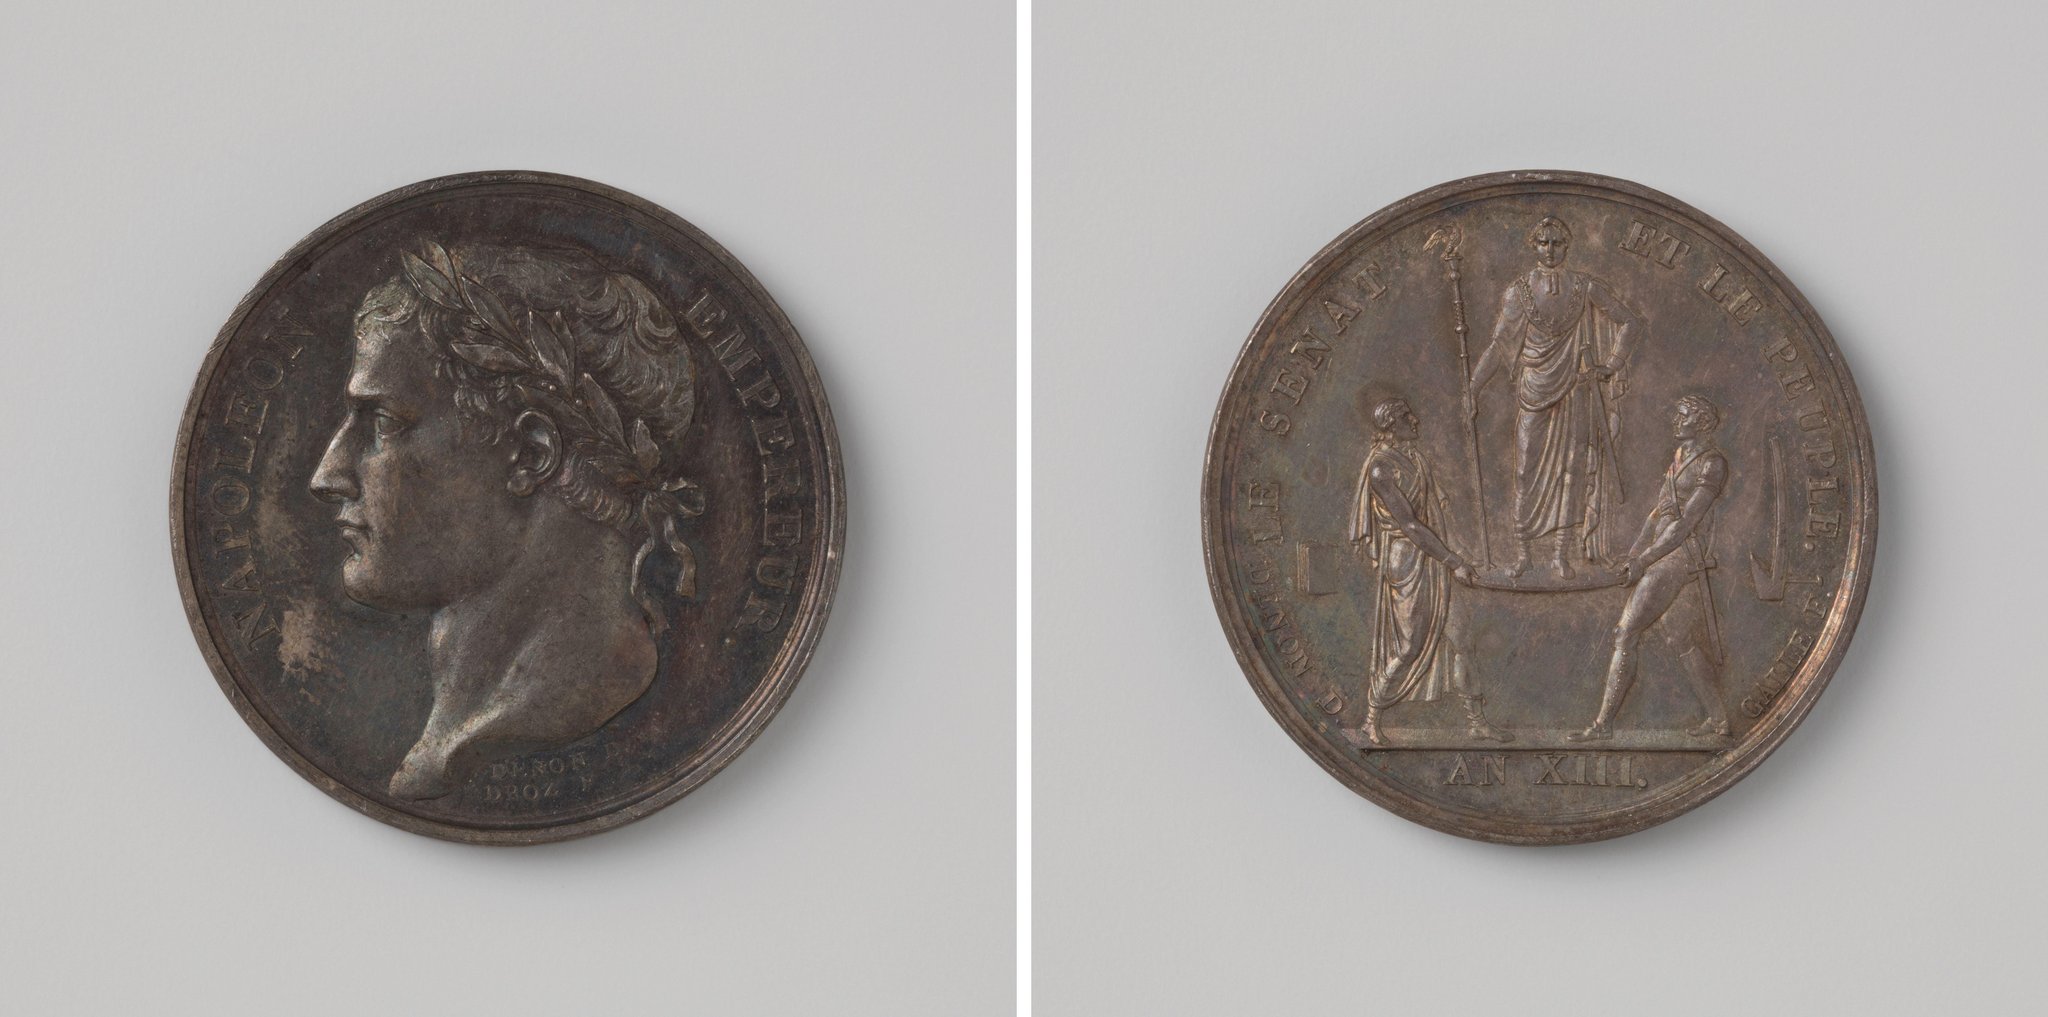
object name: history medal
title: Napoleon Bonaparte, keizer der Fransen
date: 1806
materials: silver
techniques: striking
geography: paris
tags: napoleon i (emperor of the french)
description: Zilveren penning. Voorzijde: borststuk man met lauwerkrans binnen omschrift. Keerzijde: Napoleon met veldteken in hand staat op schild dat wordt getild door Senaat en Volk binnen omschrift; afsnede: jaartal